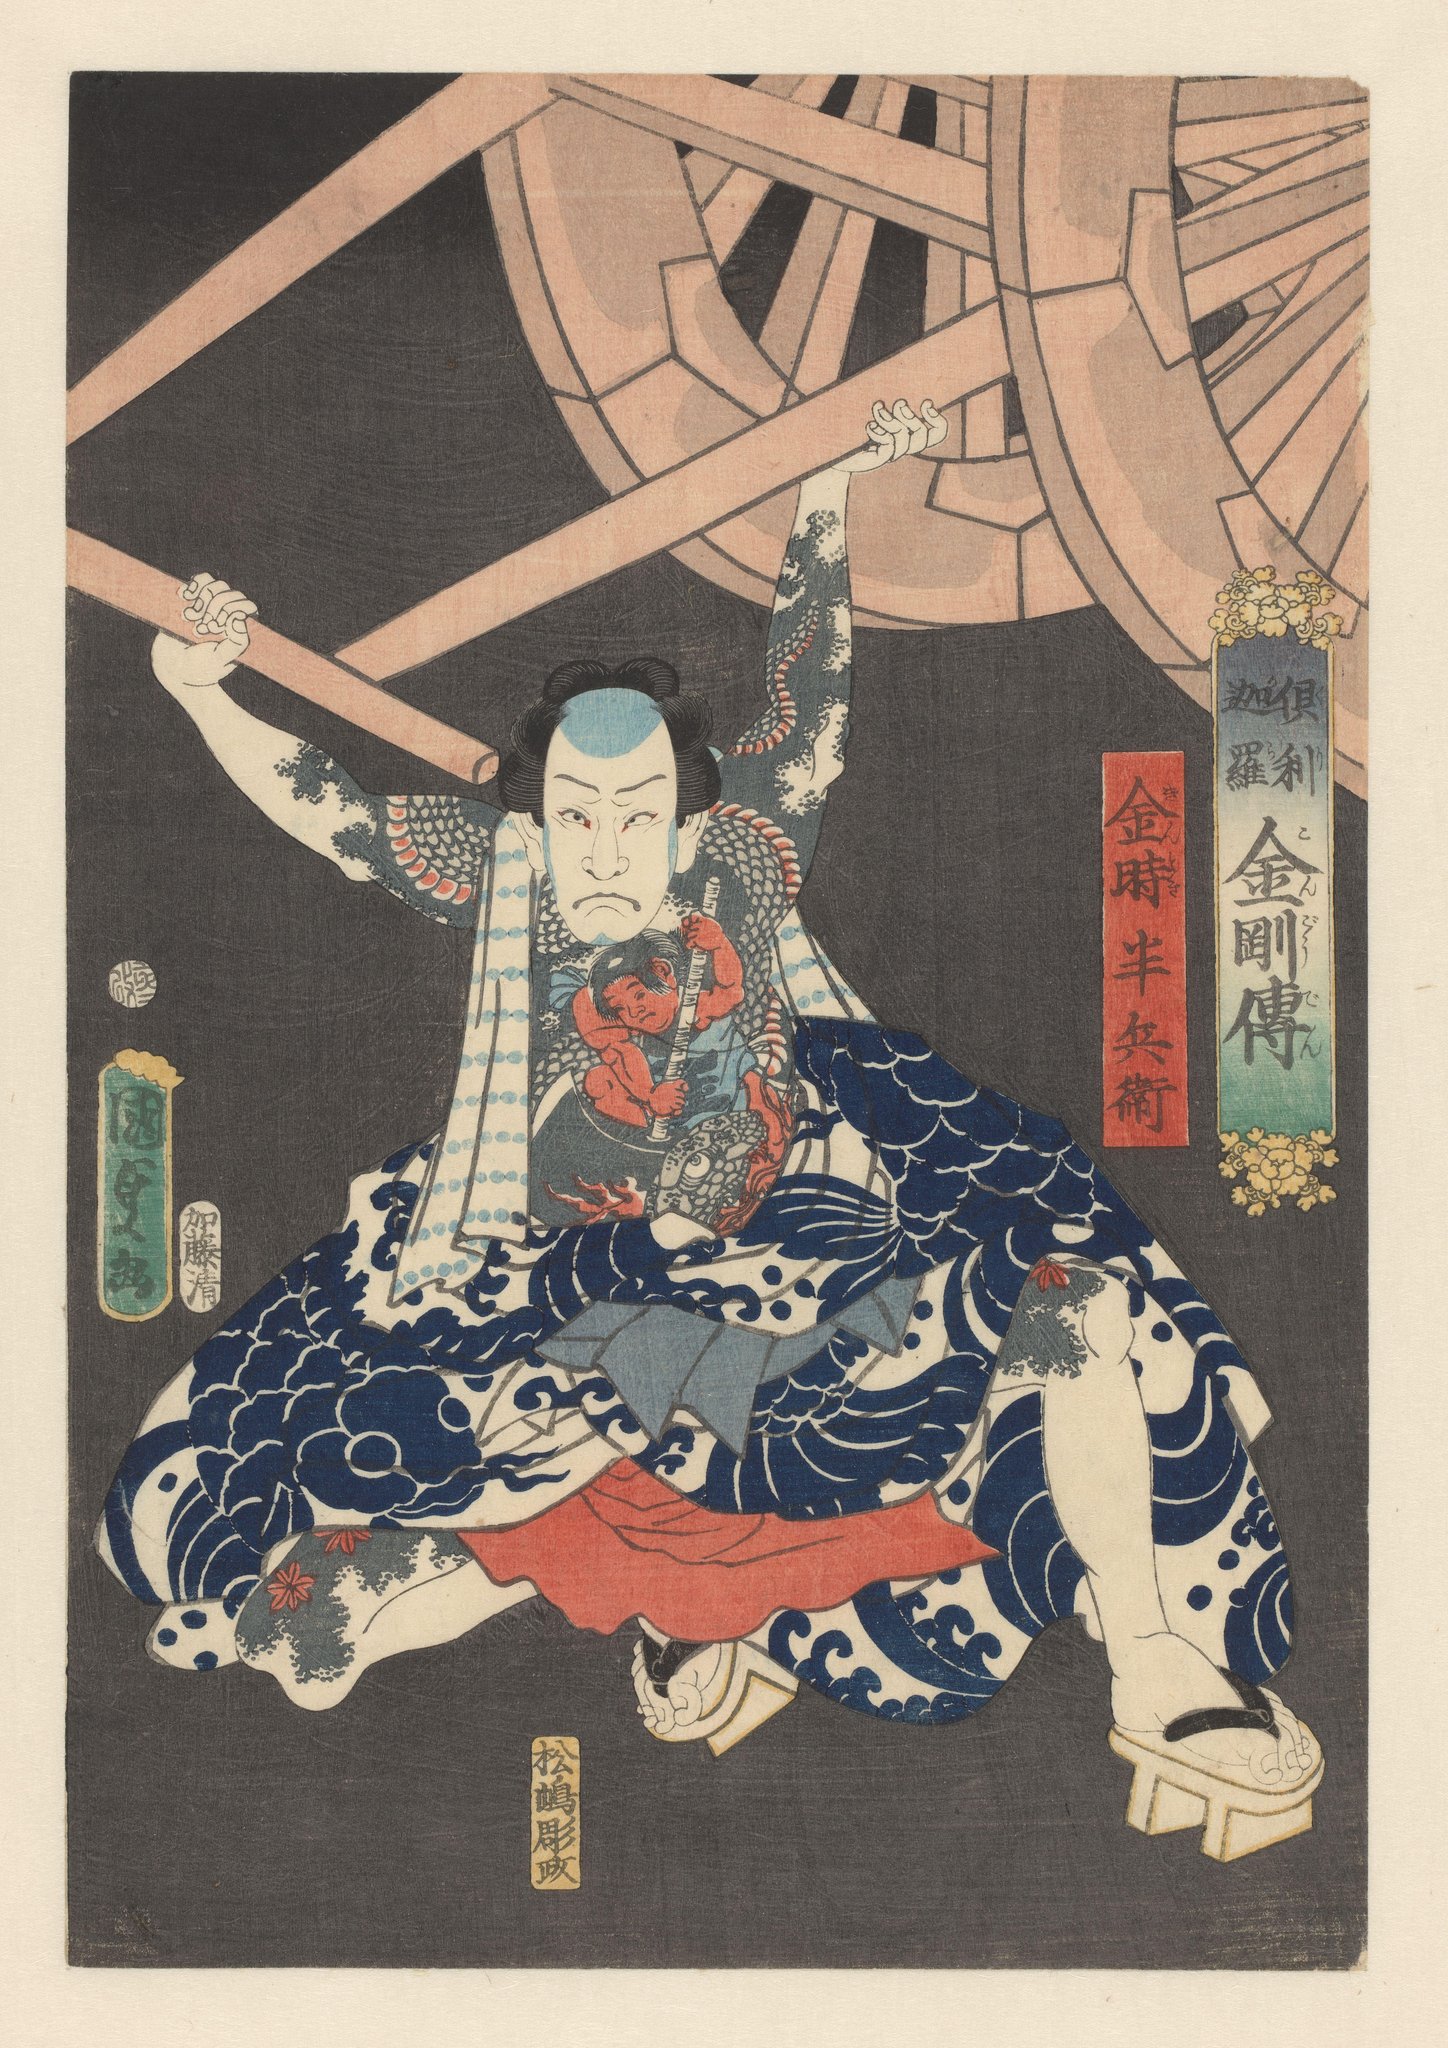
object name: print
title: Kintoki Hanbei lifting a heavy carriage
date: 1802-1863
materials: paper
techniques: woodcut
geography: japan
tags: two-wheeled, animal-drawn vehicle, adult man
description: De getatoeeerde held Kintoki Hanbei, tilt een houten kar boven zijn hoofd op.